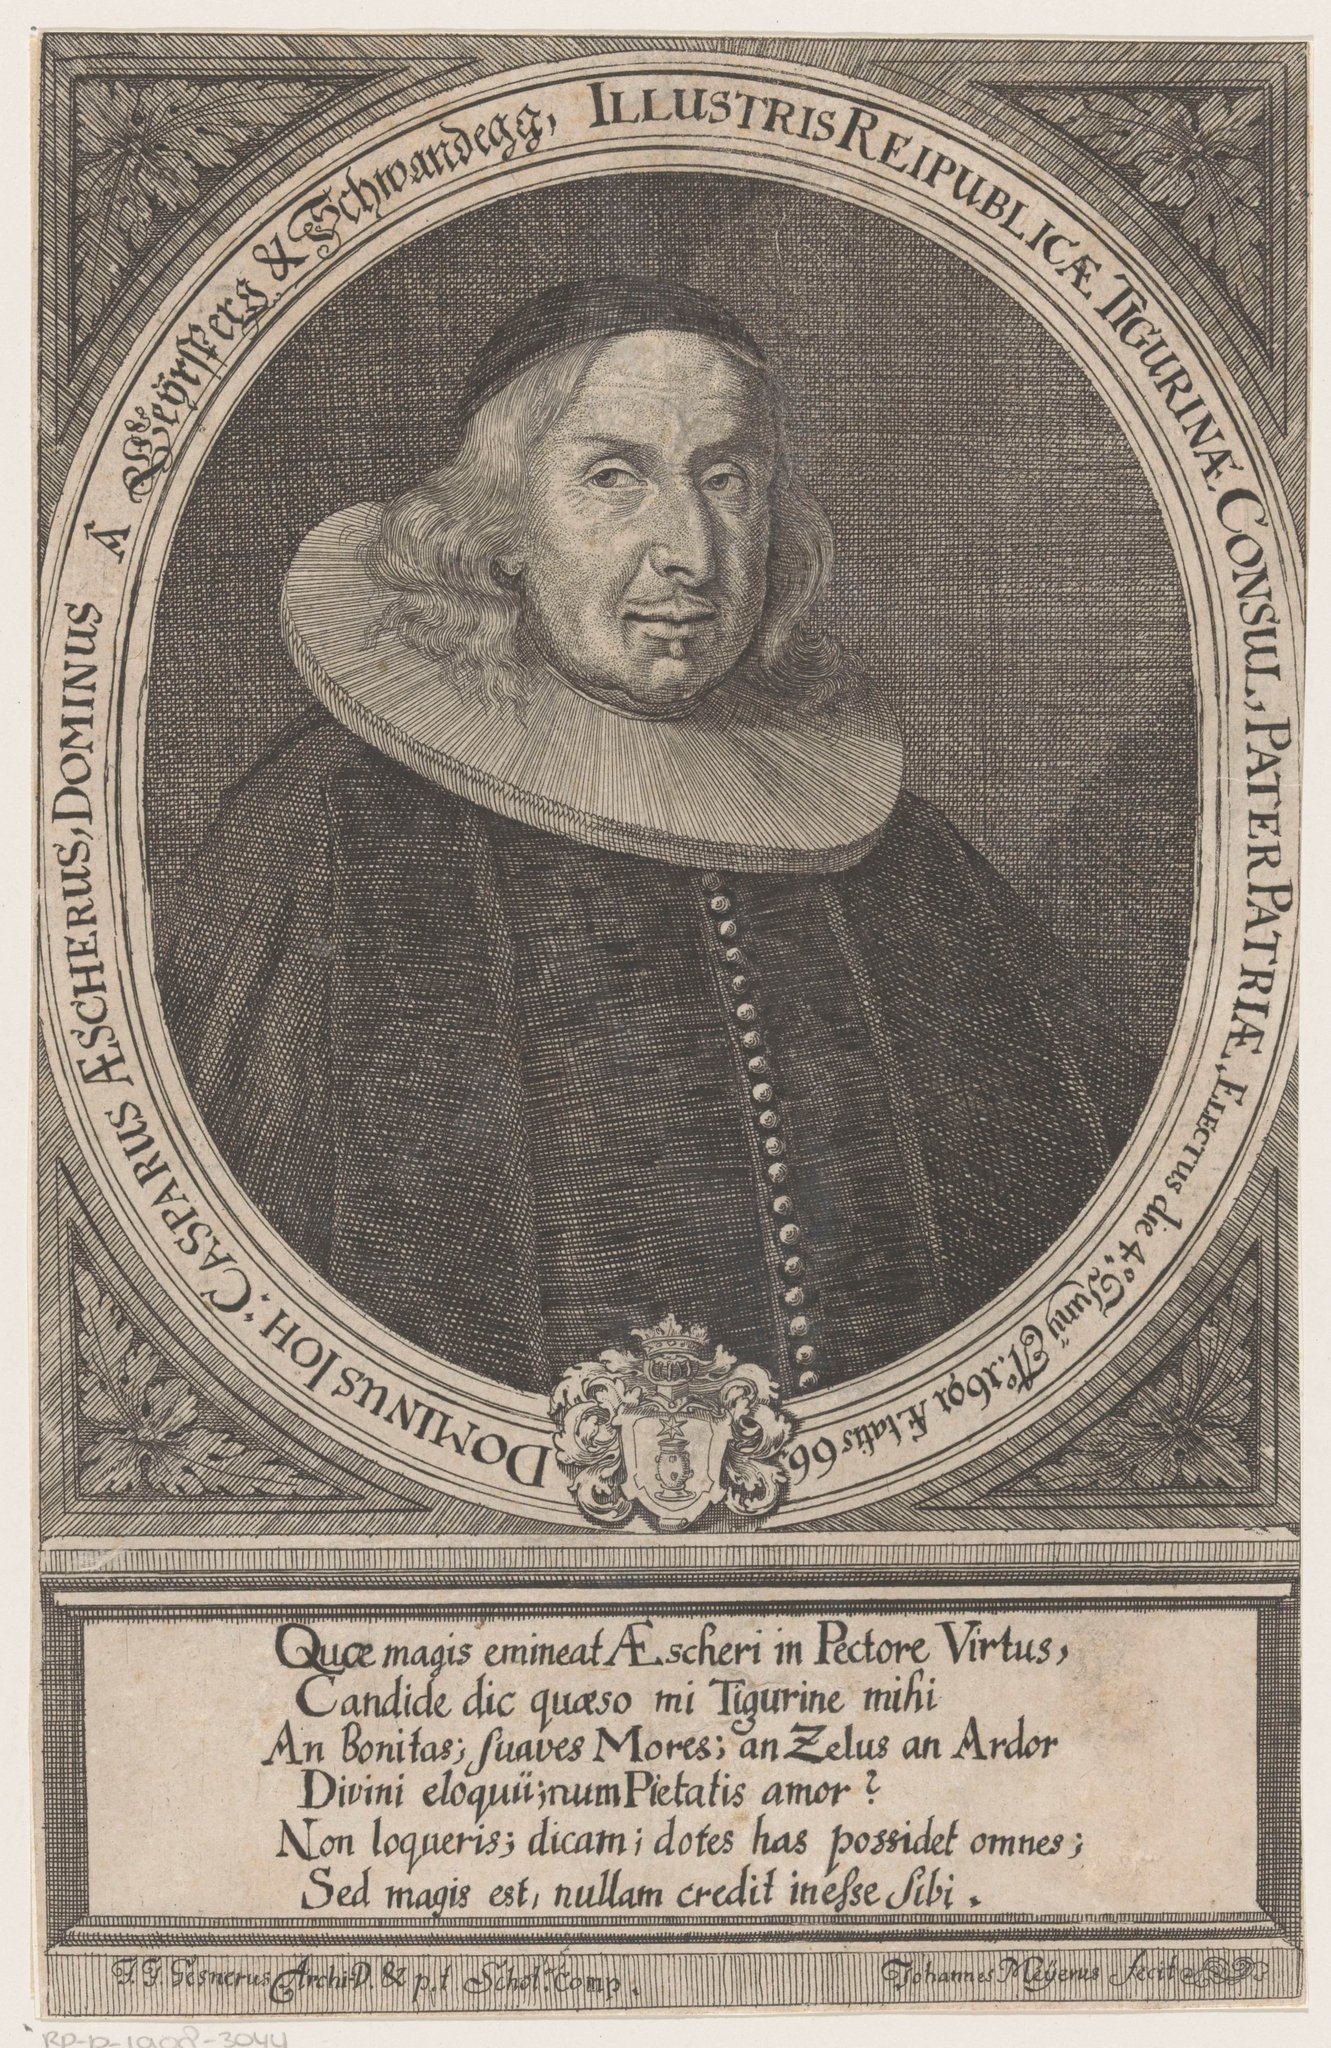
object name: print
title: Portret van Johann Caspar Aescher op 66-jarige leeftijd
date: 1691-1712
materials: paper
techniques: engraving, etching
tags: hans caspar escher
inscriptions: collector's mark: Lugt 2228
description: Portret van Johann Caspar Aescher in een geornamenteerde, ovale omlijsting met randschrift. Midden onder een wapen. In de ondermarge zes regels Latijnse tekst.